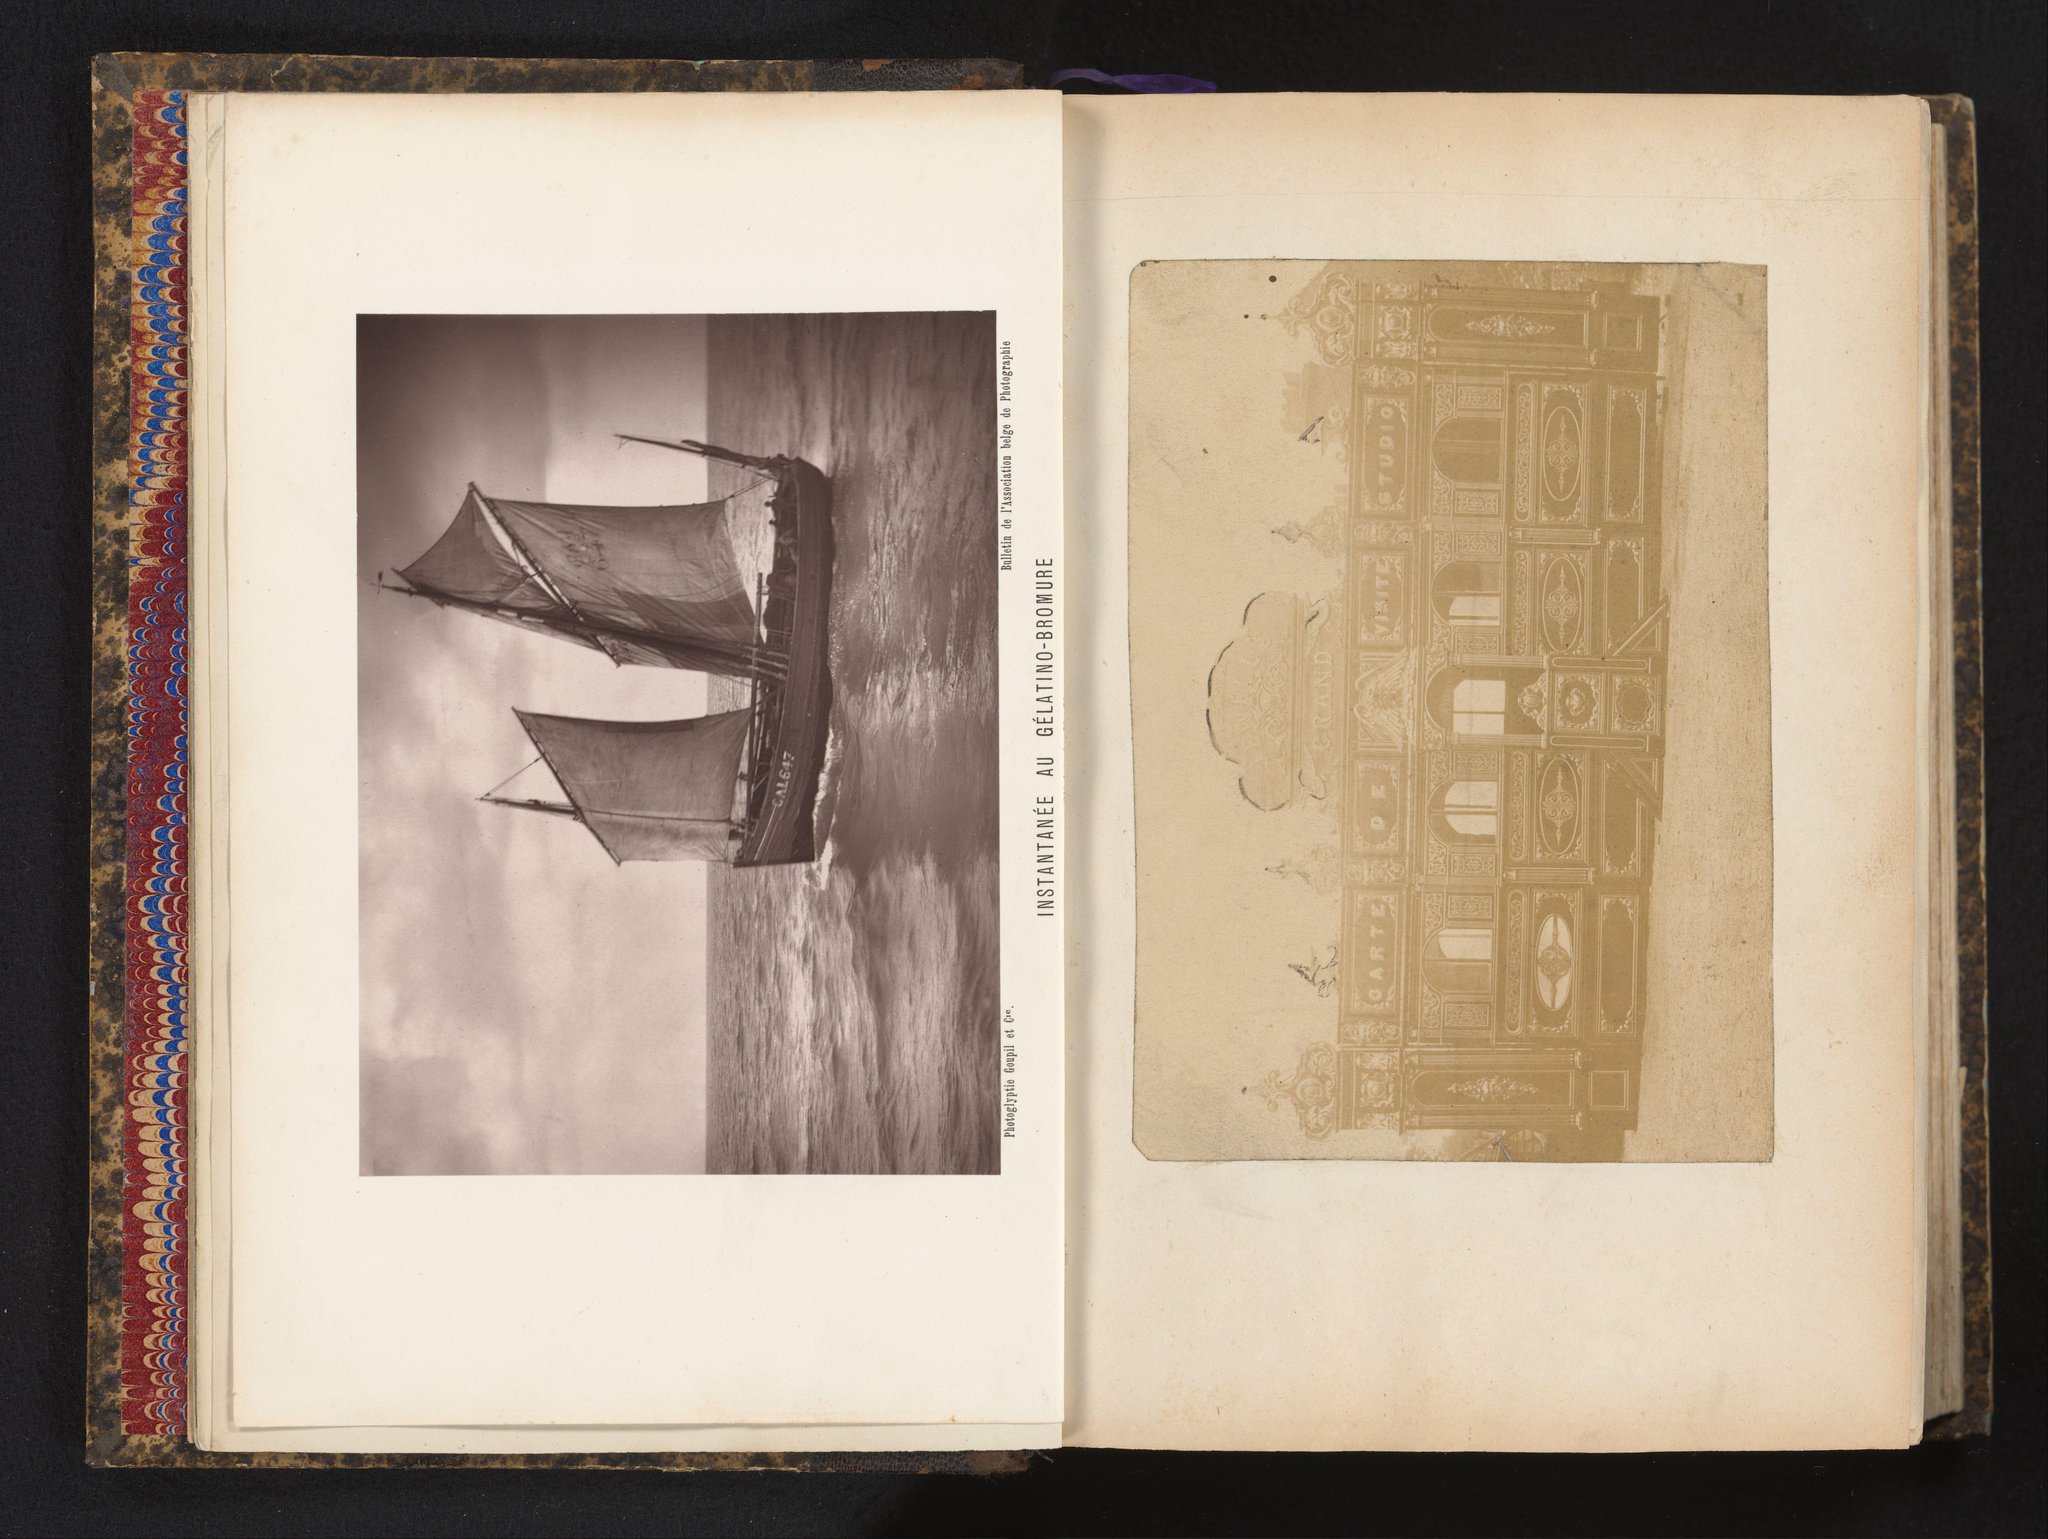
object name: page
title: Exterieur van een fotostudio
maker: Anonymous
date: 1878-1883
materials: photographic support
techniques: albumen print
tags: studio ~ photographer